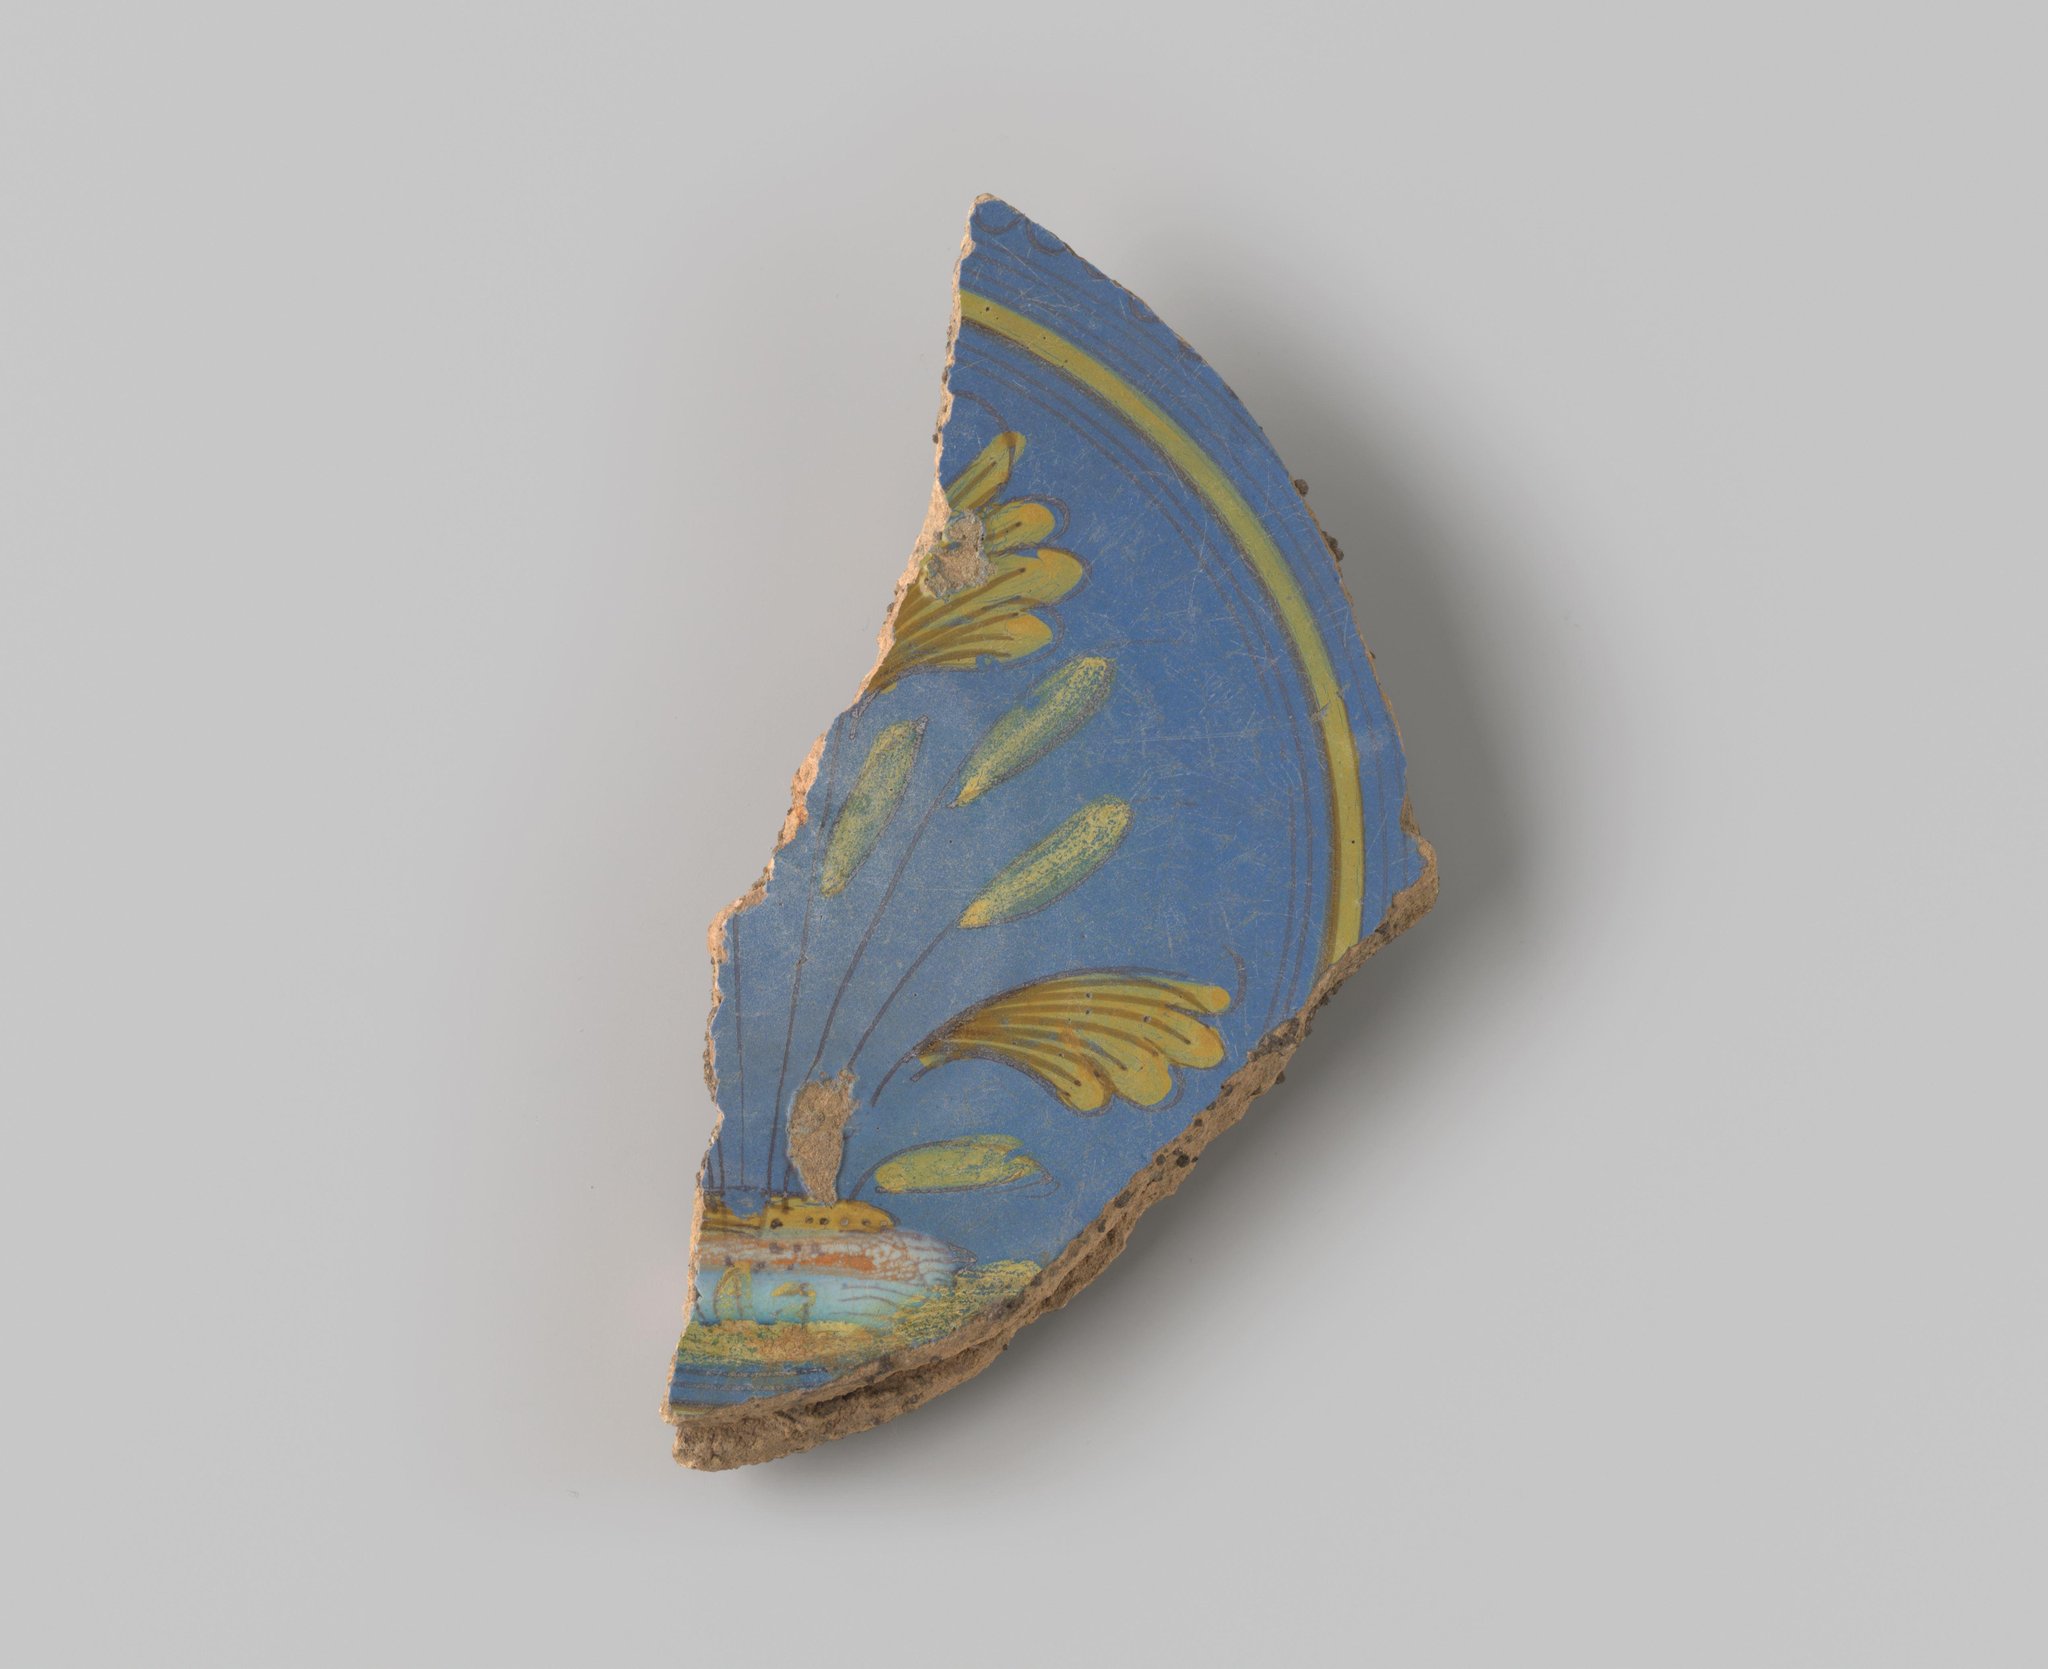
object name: fragment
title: Scherf van rossigbakkend aardewerk, aan de bovenzijde voorzien van blauw glazuur met decoratie van een tafereeltje van bloemen die in de aarde staan in bruin, wit, geel, oranje en groen, en enkele cirkels in bruin en geel eromheen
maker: Anonymous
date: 1600-1650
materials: earthenware, glaze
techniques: maiolica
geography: northern netherlands